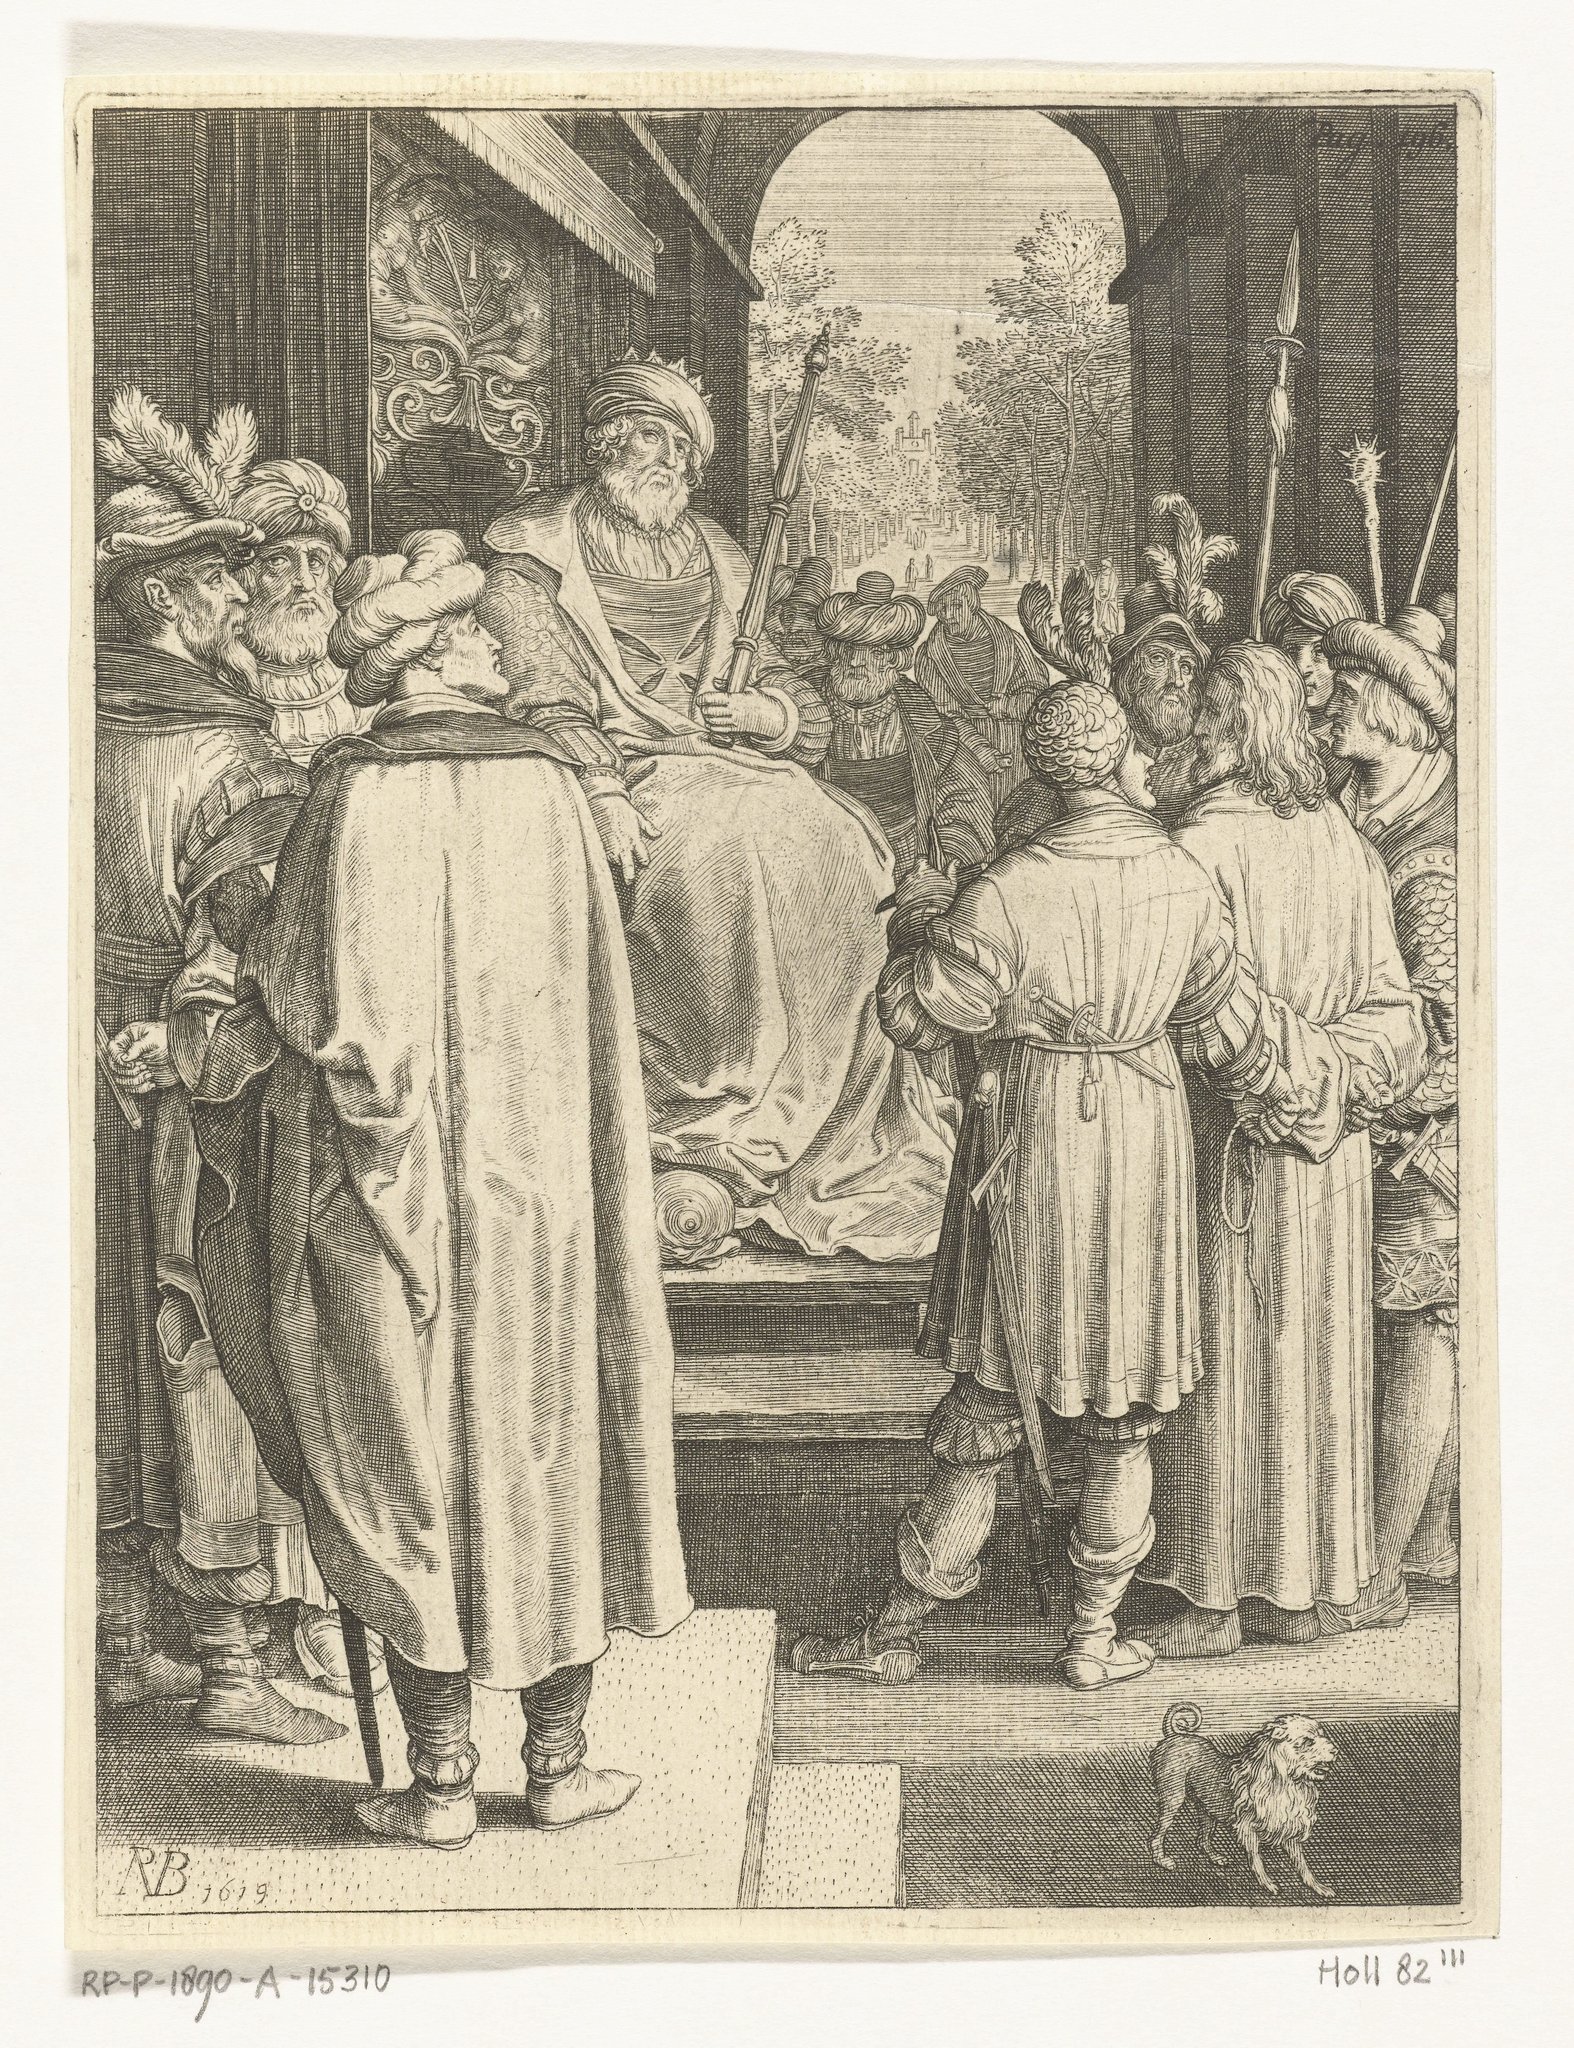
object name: print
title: Christus voor Pilatus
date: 1619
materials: paper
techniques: engraving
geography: netherlands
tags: christ before pontius pilate (matthew 27:11-26; mark 15:2-15; luke 23:2-7, 23:13-25; john 18:28 - 19:16)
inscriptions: inscription: ‘Pag. 196’, collector's mark: Lugt 2228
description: Prent uit serie van twaalf prenten met scènes uit de Passie. Reeks geïnspireerd door de prenten van Hendrick Goltzius en Lucas van Leyden. Prent gebruikt voor onbekende uitgave wat blijkt uit paginanummer rechtsboven: Pag. 196.